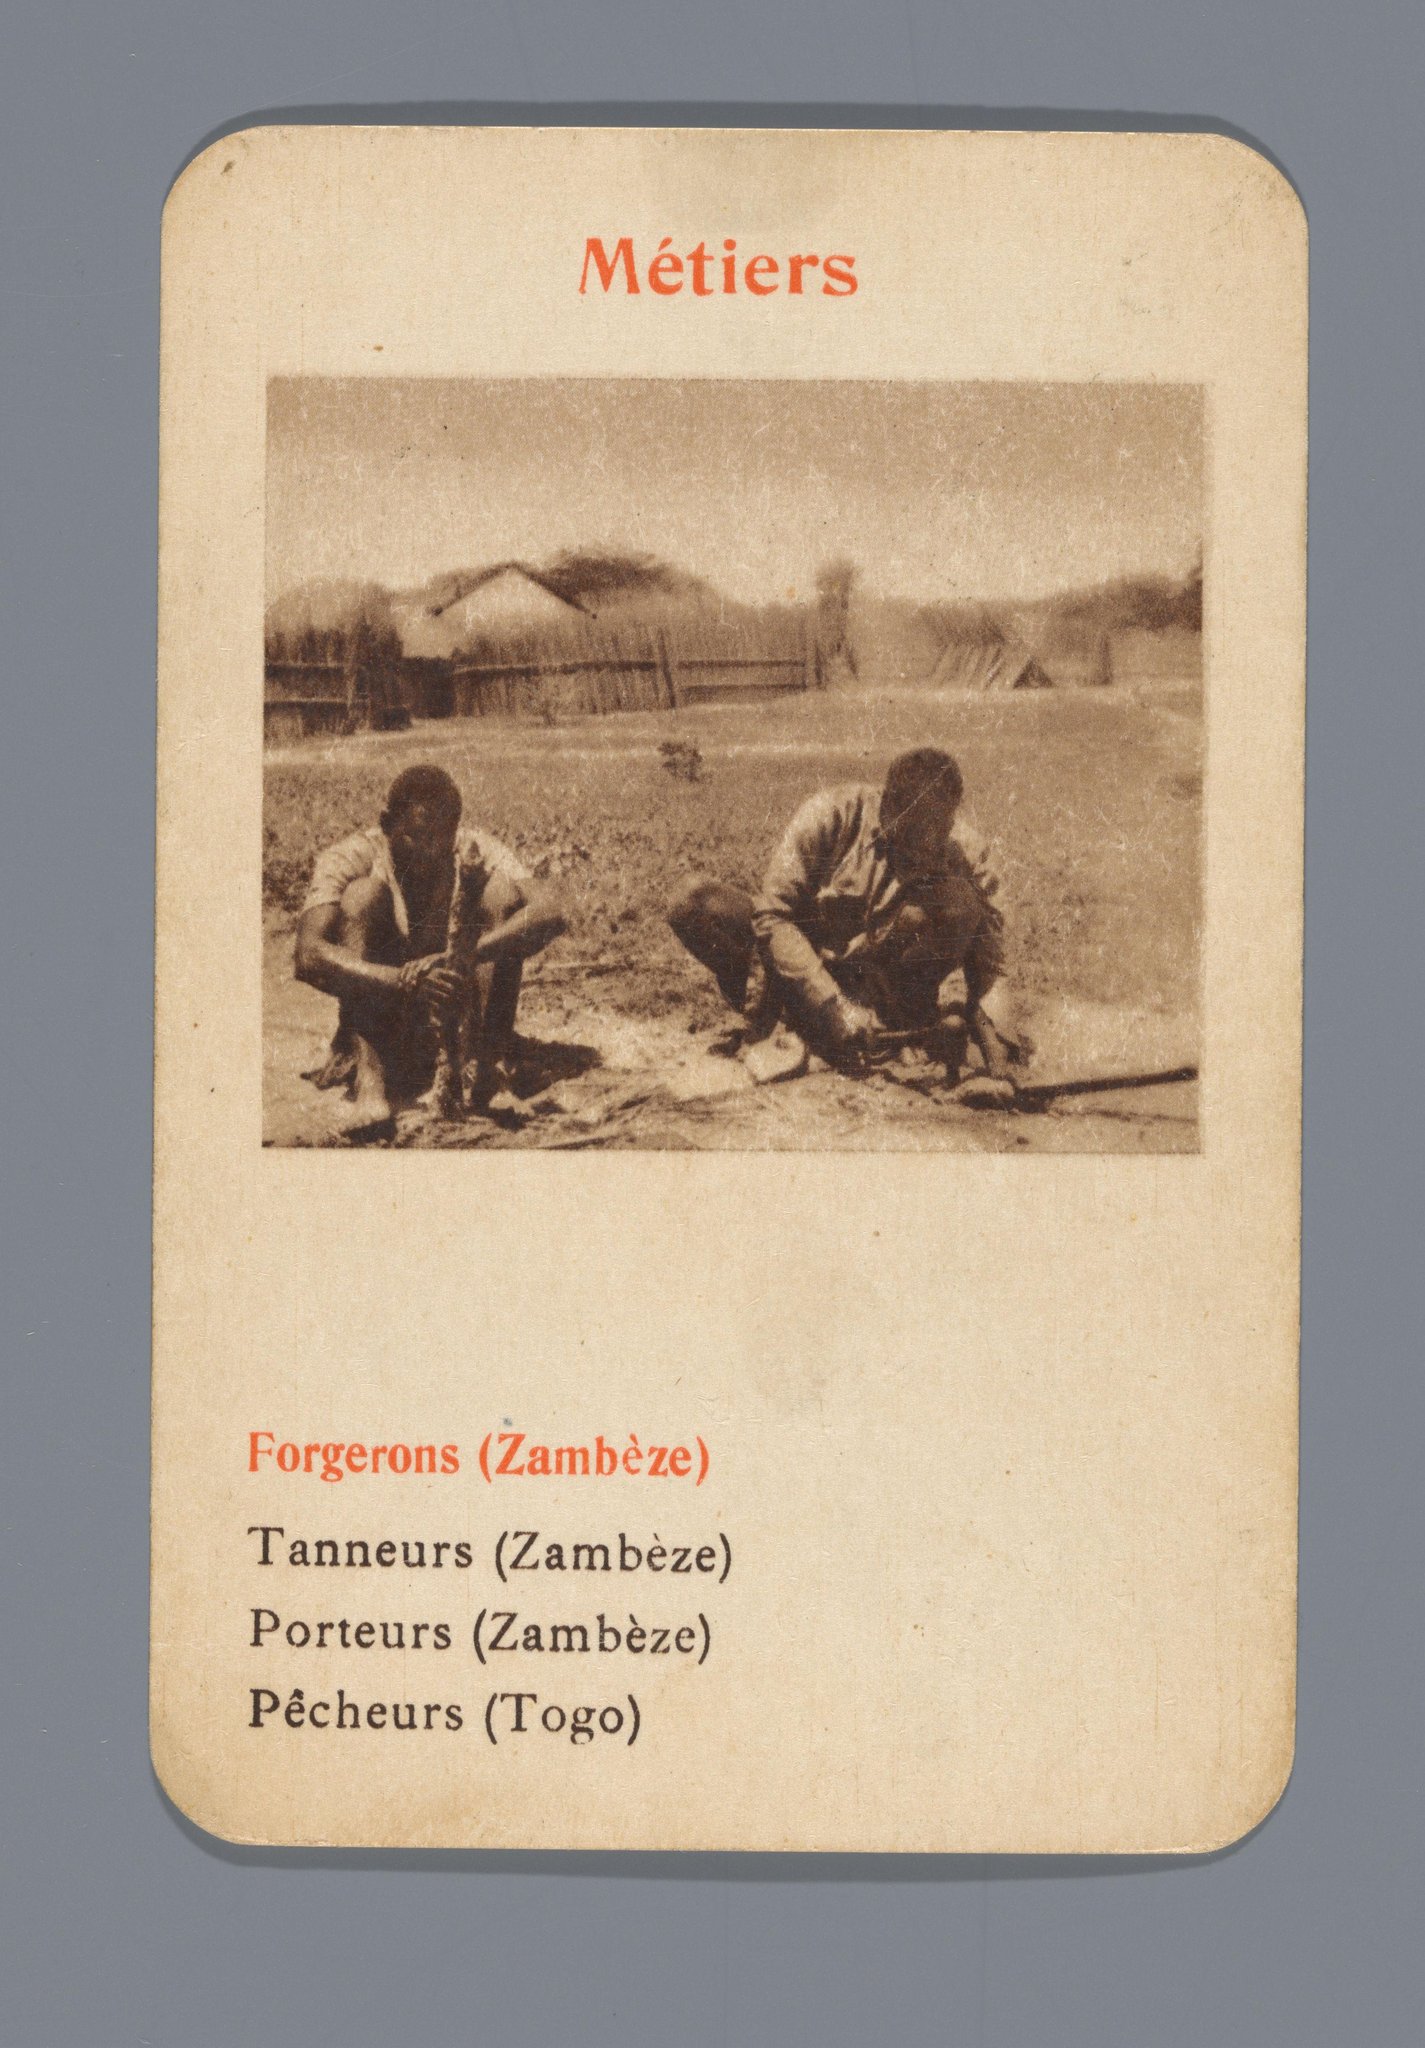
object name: card game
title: Twee smeden aan het werk in Zambia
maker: Anonymous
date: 1900-1920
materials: cardboard, paper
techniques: rotogravure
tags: card games, forging (industrial process)